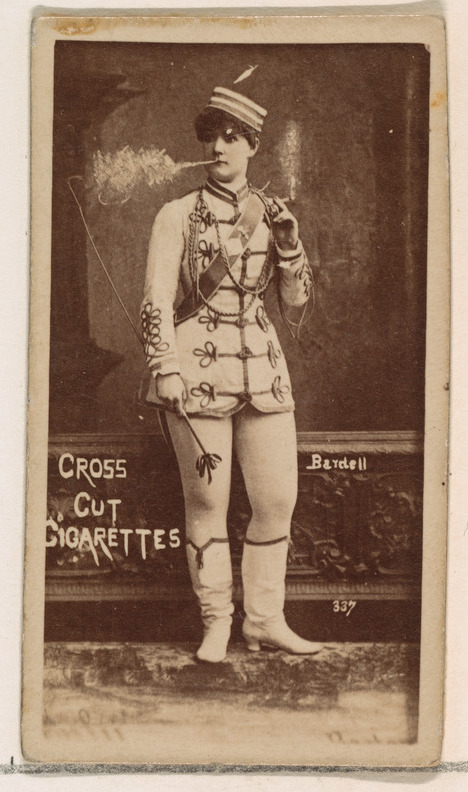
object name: print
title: Card Number 337, Bardell, from the Actors and Actresses series (N145-1) issued by Duke Sons & Co. to promote Cross Cut Cigarettes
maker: w. duke, sons & co.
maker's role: publisher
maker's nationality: american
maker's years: 1870-1920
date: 1880-1889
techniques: albumen silver print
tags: portraits,women,smoking,actresses